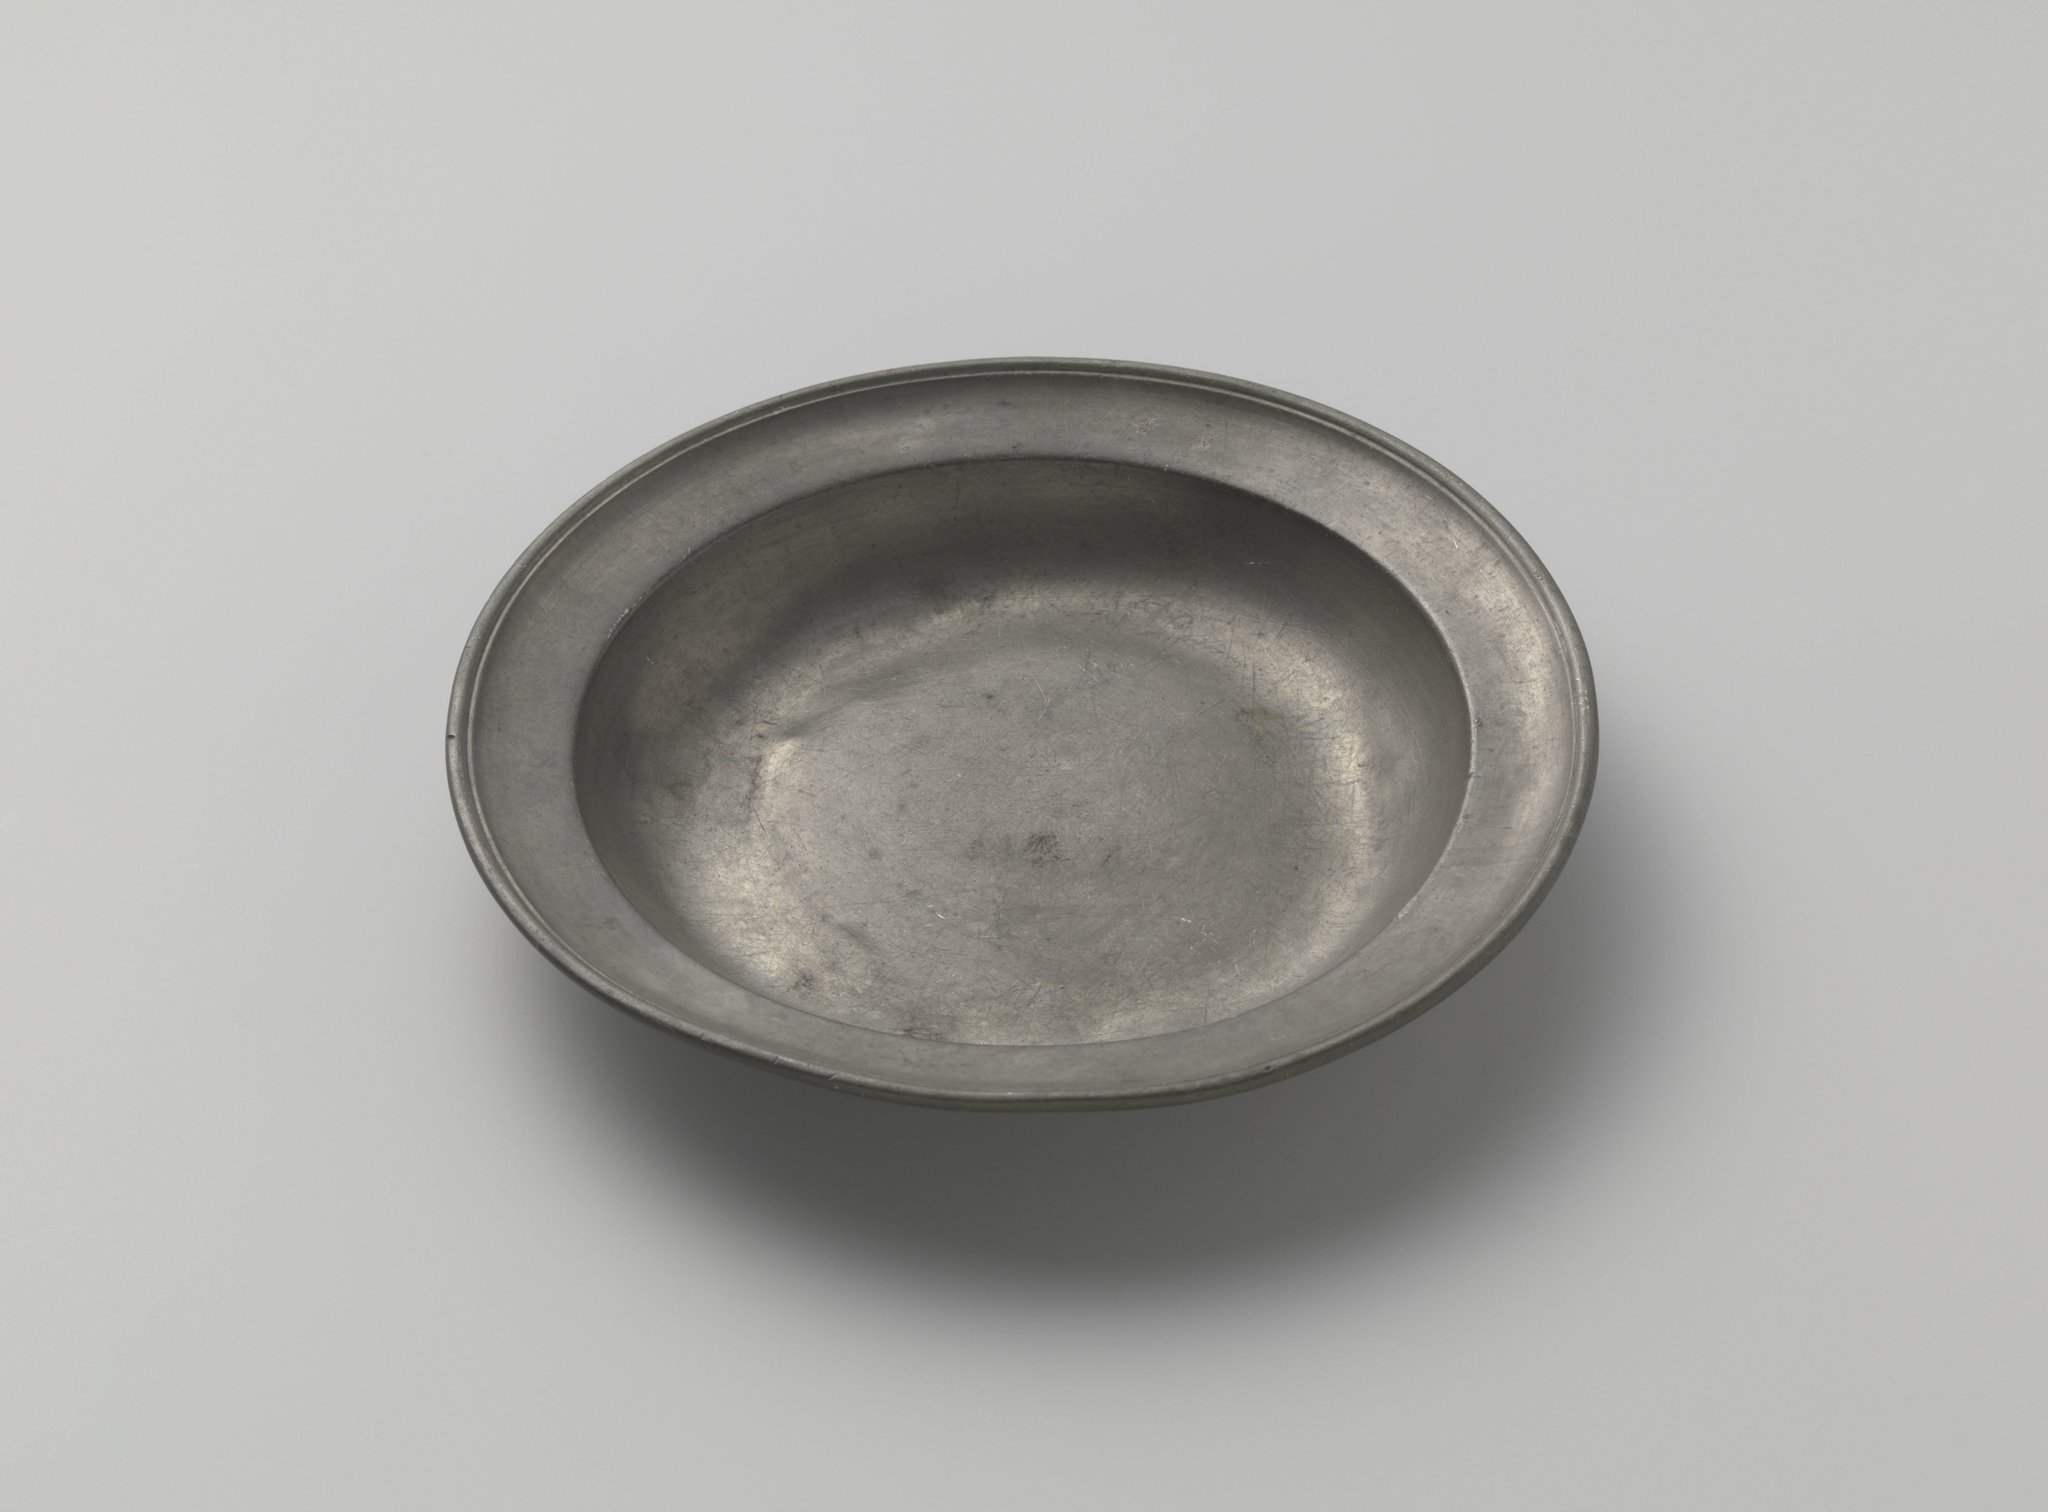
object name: plate dish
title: Rond bord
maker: Anonymous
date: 1700-1800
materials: tin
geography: low countries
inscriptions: quality mark, quality mark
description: Rond bord van tin. De dunne rand is omgeslagen.